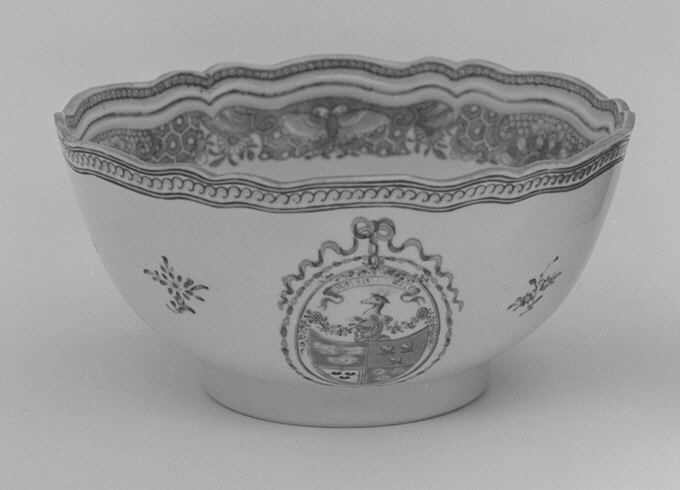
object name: bowl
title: Bowl (part of a service)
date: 1770-1785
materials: hard paste porcelain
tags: coat of arms